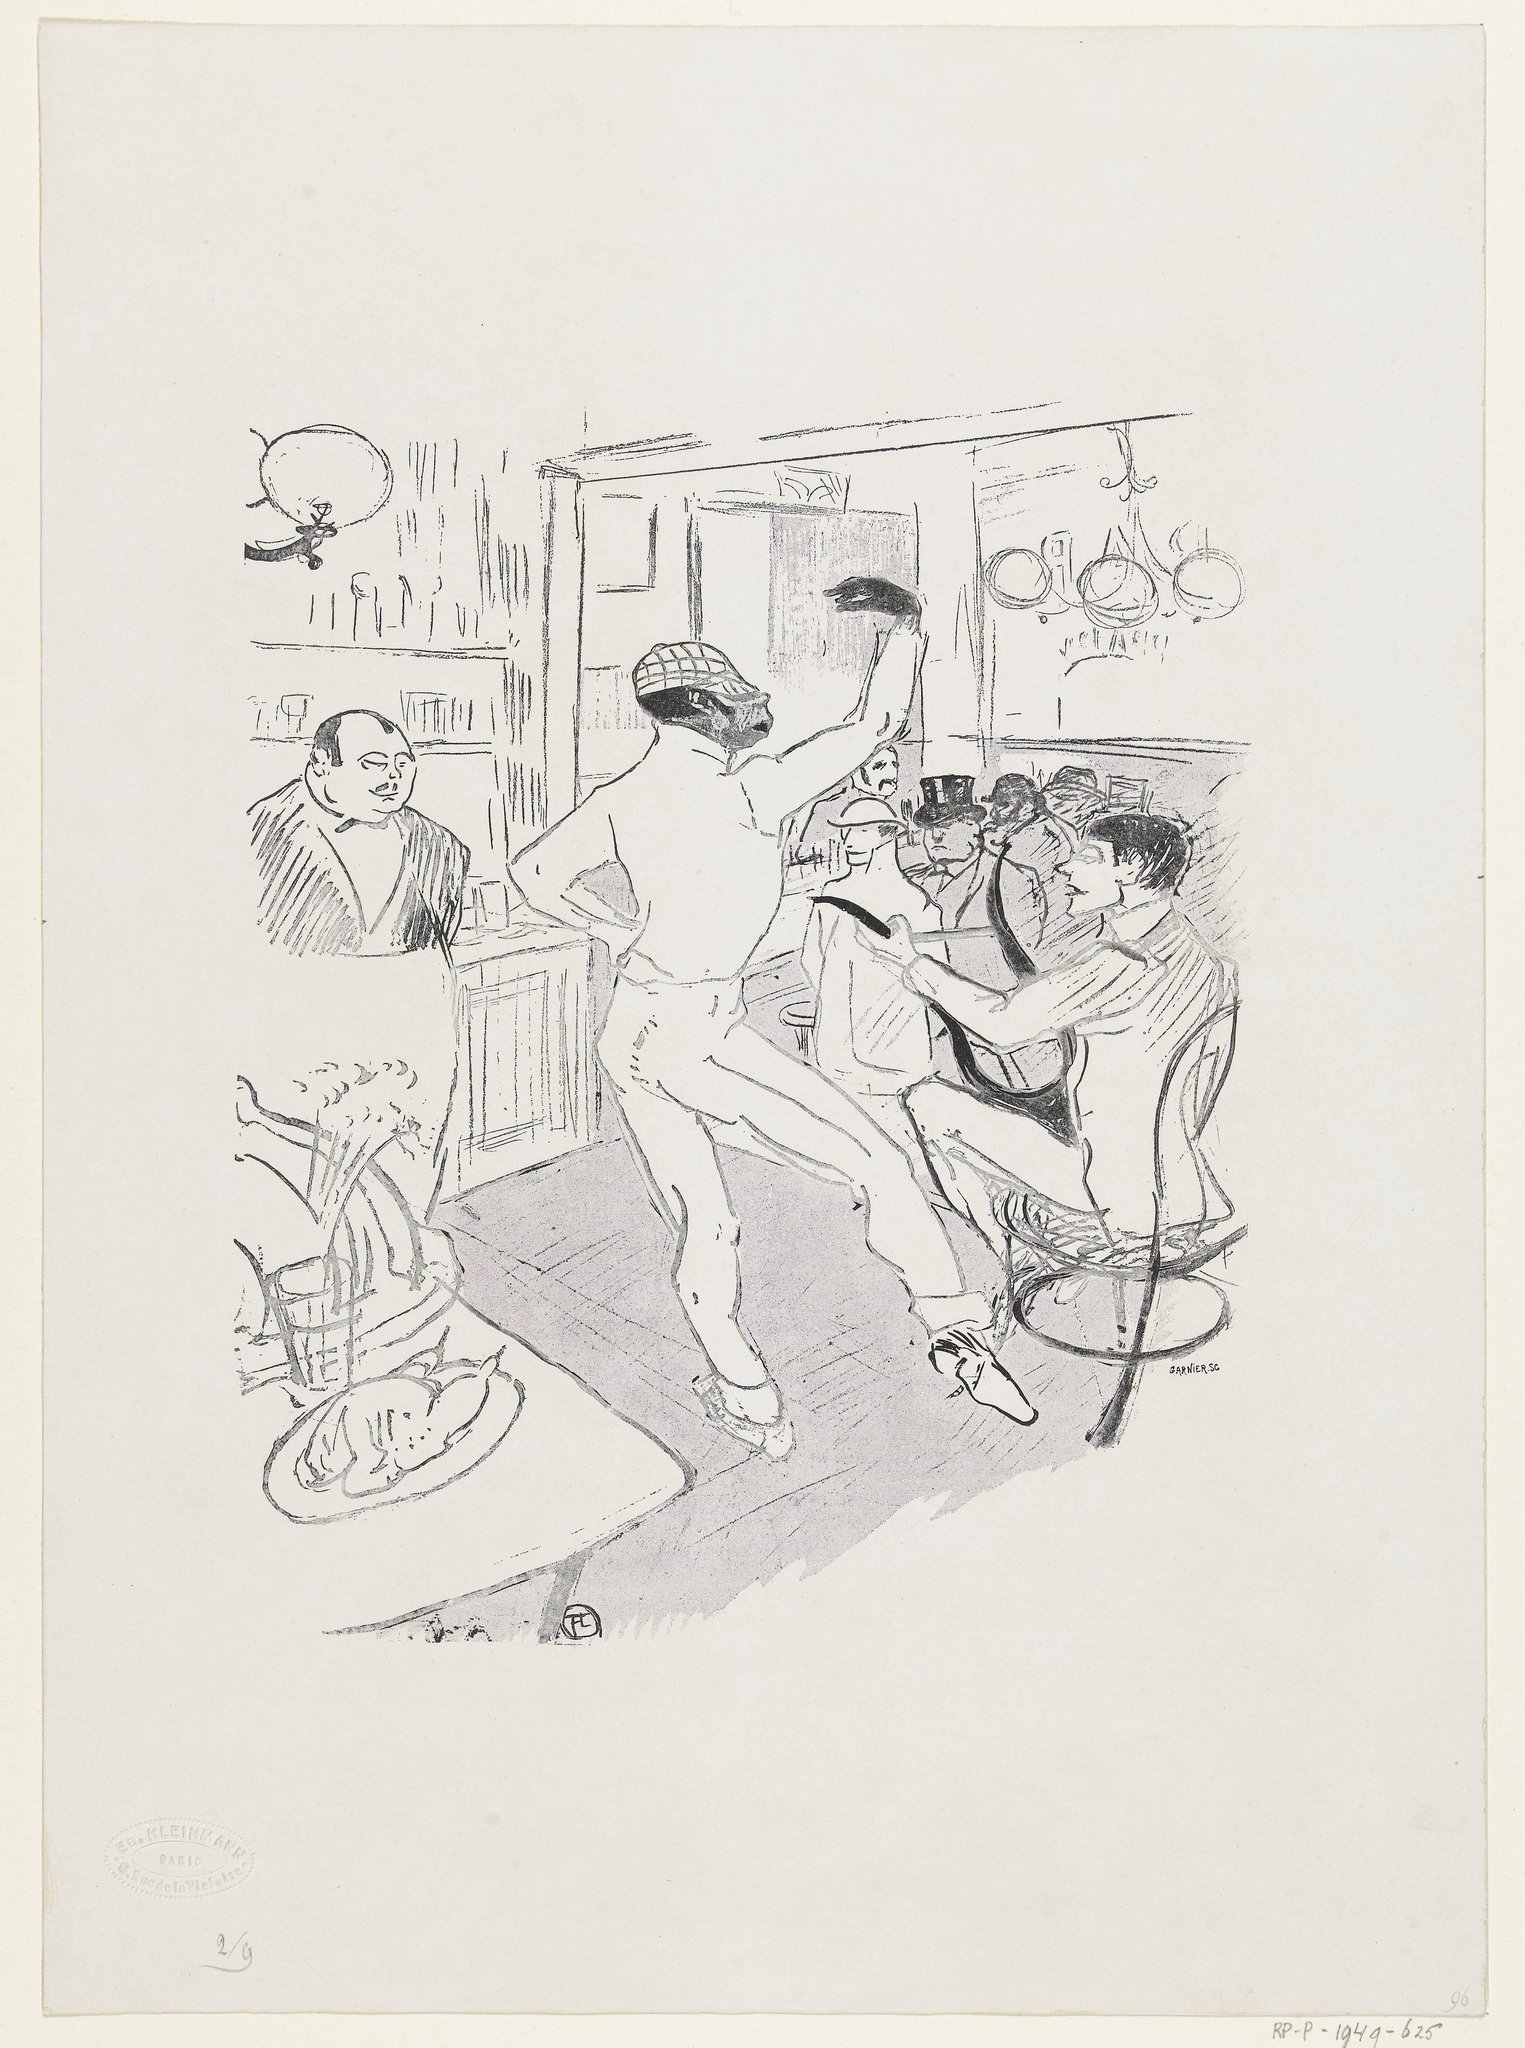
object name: reproduction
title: Portret van dansende zwarte clown Chocolat in Engelse Bar in Parijs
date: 1896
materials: paper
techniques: printing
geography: paris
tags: art (+ performing ~ music), clown, paris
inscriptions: check stamp: Lugt 1573, collector's mark: Lugt 2228, collector's mark: Lugt 2760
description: Proefdruk voor reproductie in het satirisch tijdschrift Le Rire, Parijs, 28-03-1896. Toulouse-Lautrec maakte verschillende tekeningen voor reproducties in dit tijdschrift. Hij koos daarvoor onderwerpen uit het dagelijks leven maar ook beroemdheden. De illustratie in Le Rire is veel kleurrijker. Dit werk wordt niet beschreven bij Wittrock 1985.